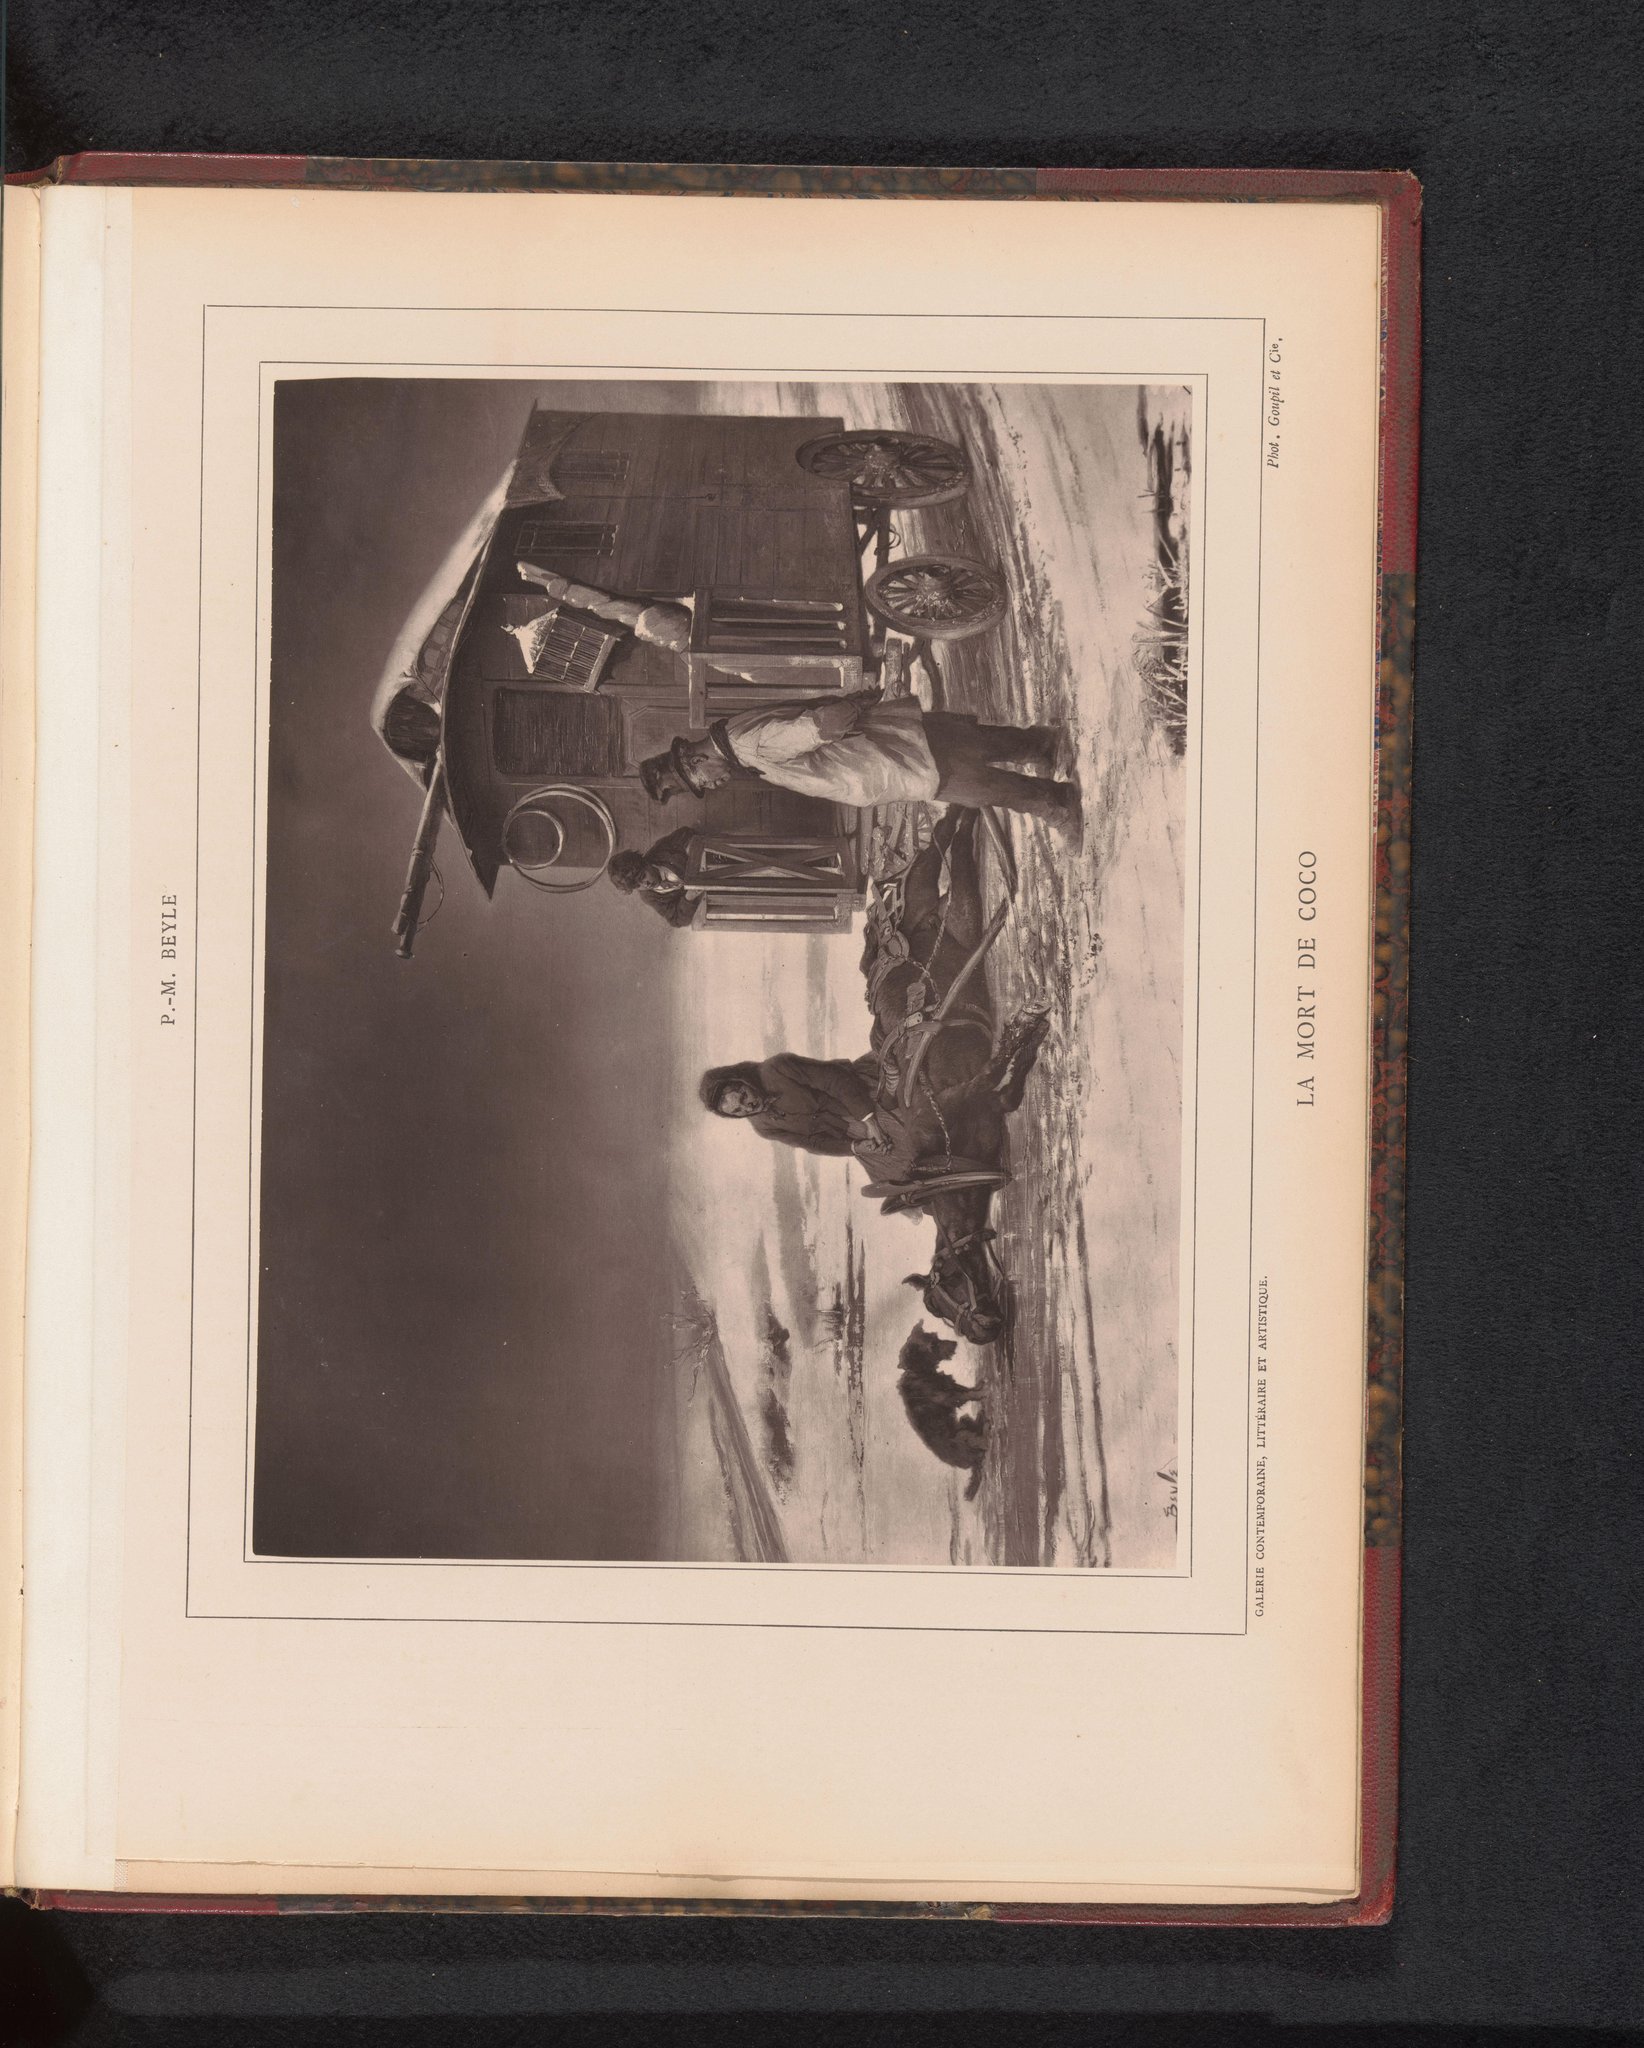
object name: page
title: Reproductie van een schilderij van een huifkar met een dood paard door Pierre-Marie Beyle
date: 1873-1878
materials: paper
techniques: woodburytype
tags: four-wheeled vehicle drawn by one animal, horse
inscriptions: inscription: ‘Galerie Contemporaine, Littéraire et Artistique.’